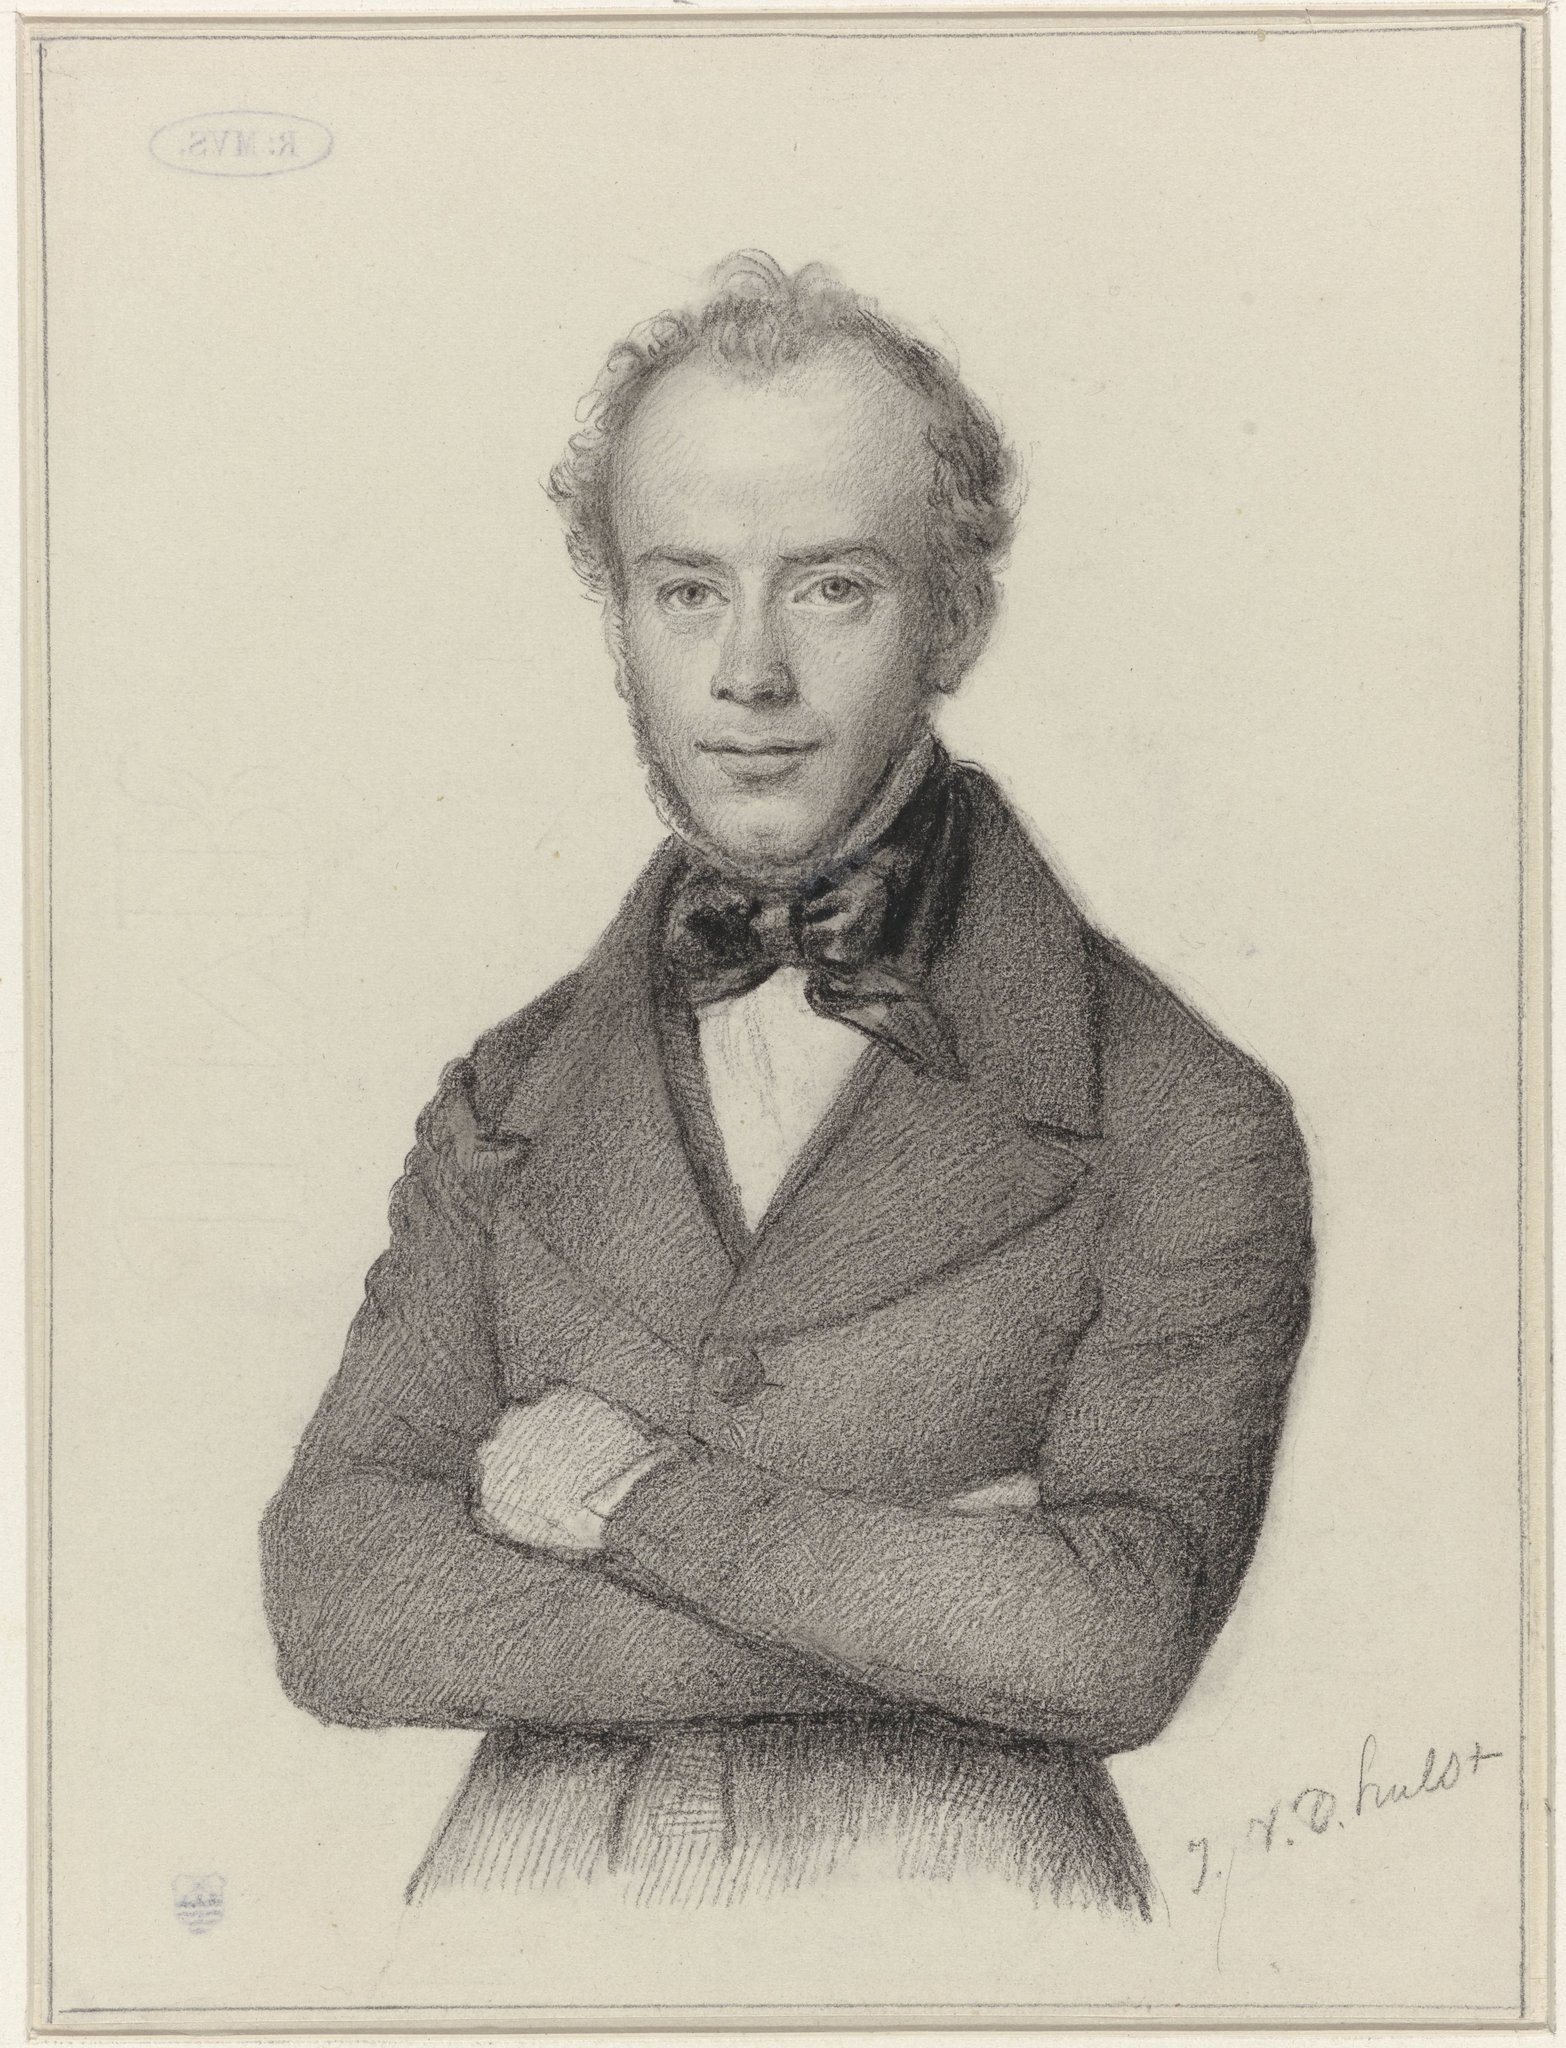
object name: drawing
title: Portret van Johannes Adrianus van der Drift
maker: jean-baptiste van der hulst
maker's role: draughtsman, painter, print maker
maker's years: 1790-1862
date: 1800-1862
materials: chalk, paper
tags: the hague, print maker, johannes adrianus van der drift, adult man, historical persons, portrait, self-portrait of painter, portrait, self-portrait of artist, portrait, self-portrait of draughtsman